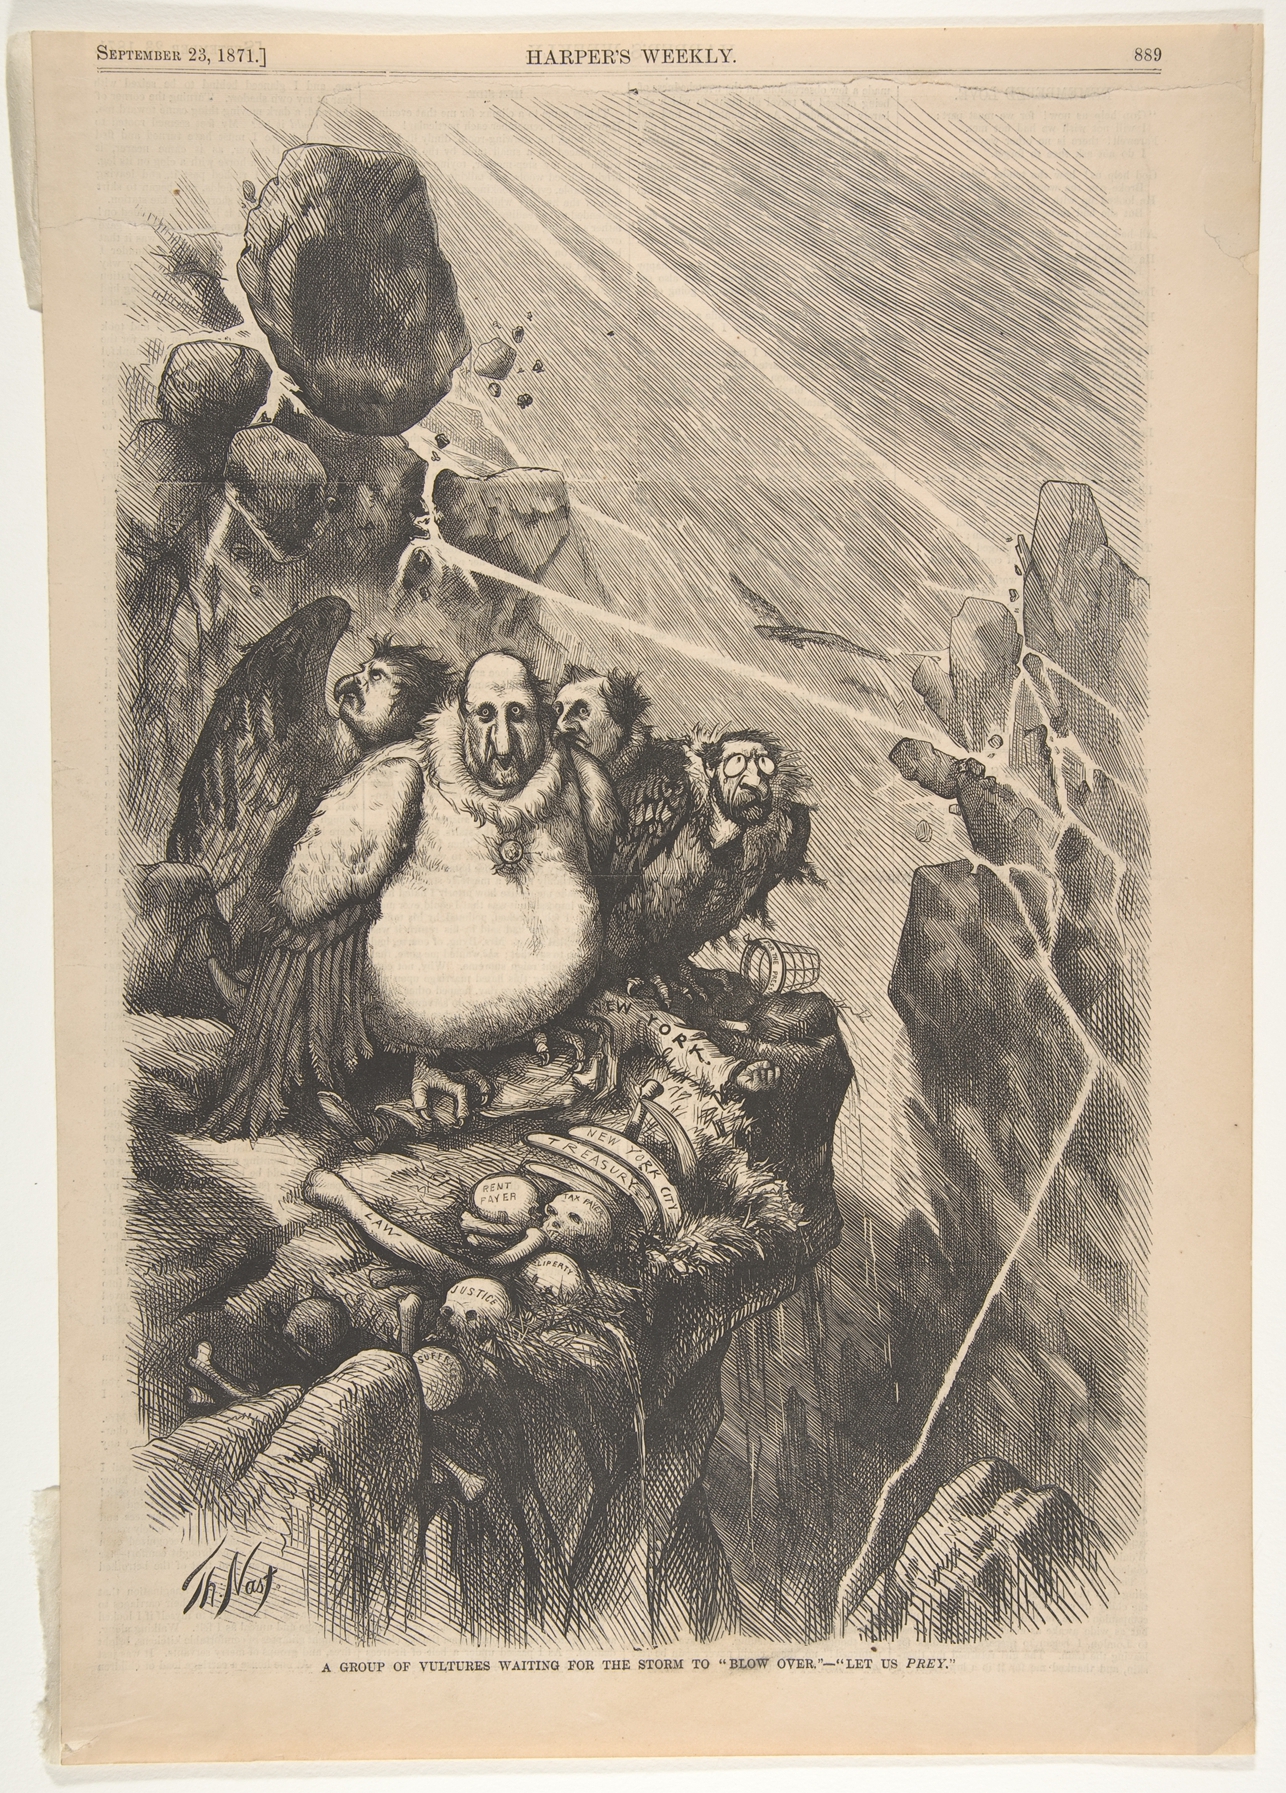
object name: print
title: A Group of Vultures Waiting for the Storm to "Blow Over"–"Let Us Prey" (from "Harper's Weekly," vol. 15, p. 889)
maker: thomas nast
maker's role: artist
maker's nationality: american, born germany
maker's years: 1840-1902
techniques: engraving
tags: birds,caricature,politics